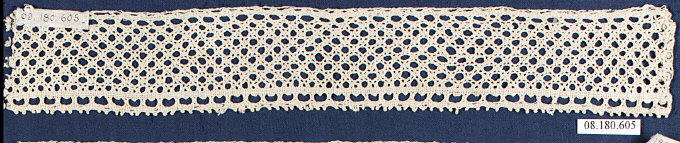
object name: piece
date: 1701-1800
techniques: lace